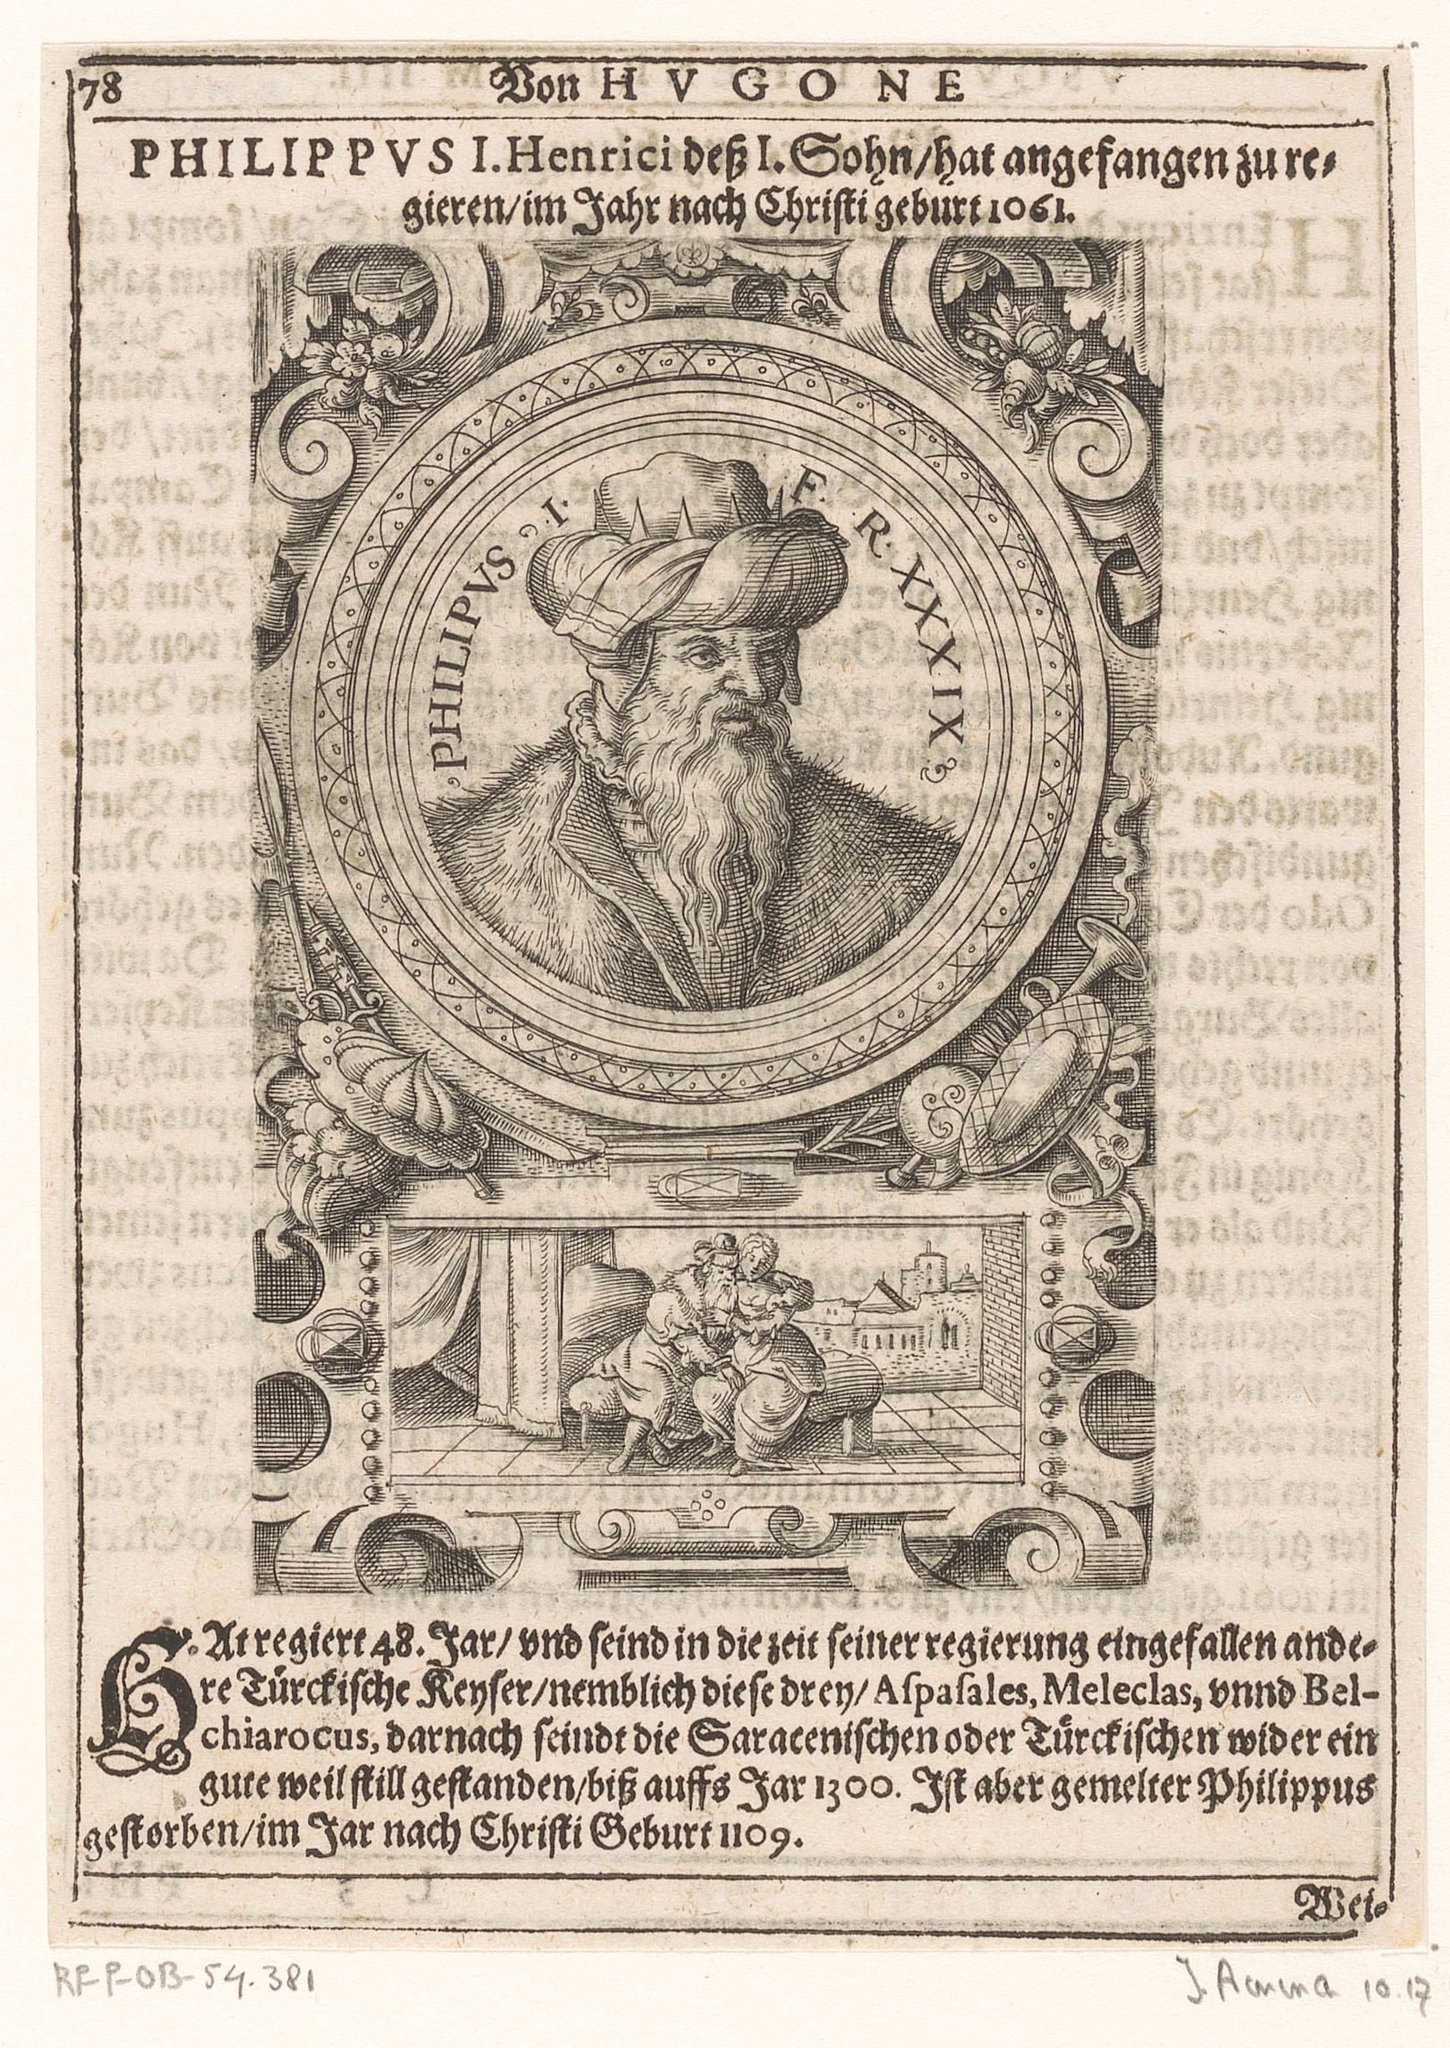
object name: book illustration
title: Portret van Filips I, koning van Frankrijk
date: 1598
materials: paper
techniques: engraving, etching, intaglio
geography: nuremberg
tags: scrollwork, strapwork ~ ornament, historical persons, ruler, sovereign, couple of lovers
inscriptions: number: ‘158’, collector's mark: Lugt 2228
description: Prent afkomstig uit de publicatie: Michael Eizinger. Könige in Frankreich. Keulen: Johann Bussemacher, 1598, p. 78. De publicatie bevat prenten van Jost Amman en Virgil Solis.